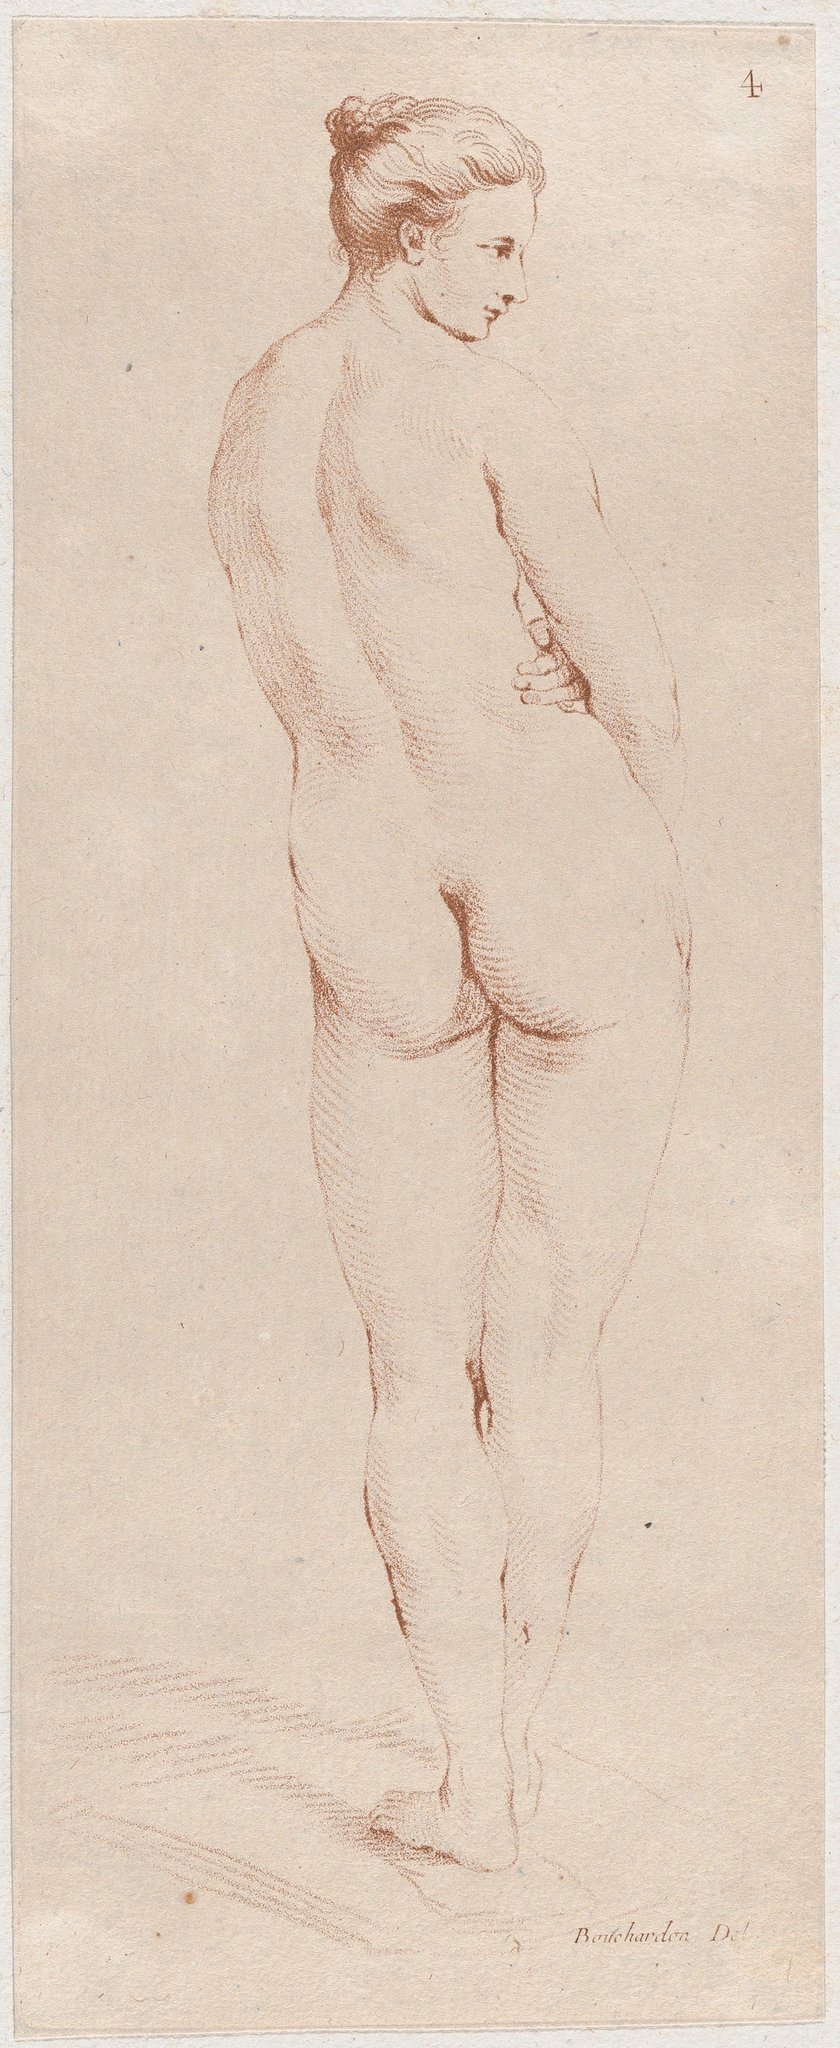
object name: print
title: Standing Female Nude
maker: gilles-antoine demarteau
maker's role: artist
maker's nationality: french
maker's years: 1756-1802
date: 1701-1800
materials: chalk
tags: female nudes